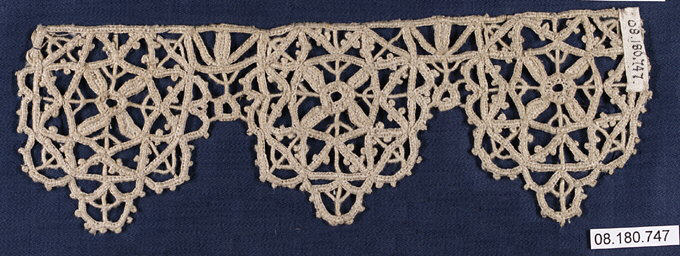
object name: fragment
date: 1801-1900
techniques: lace